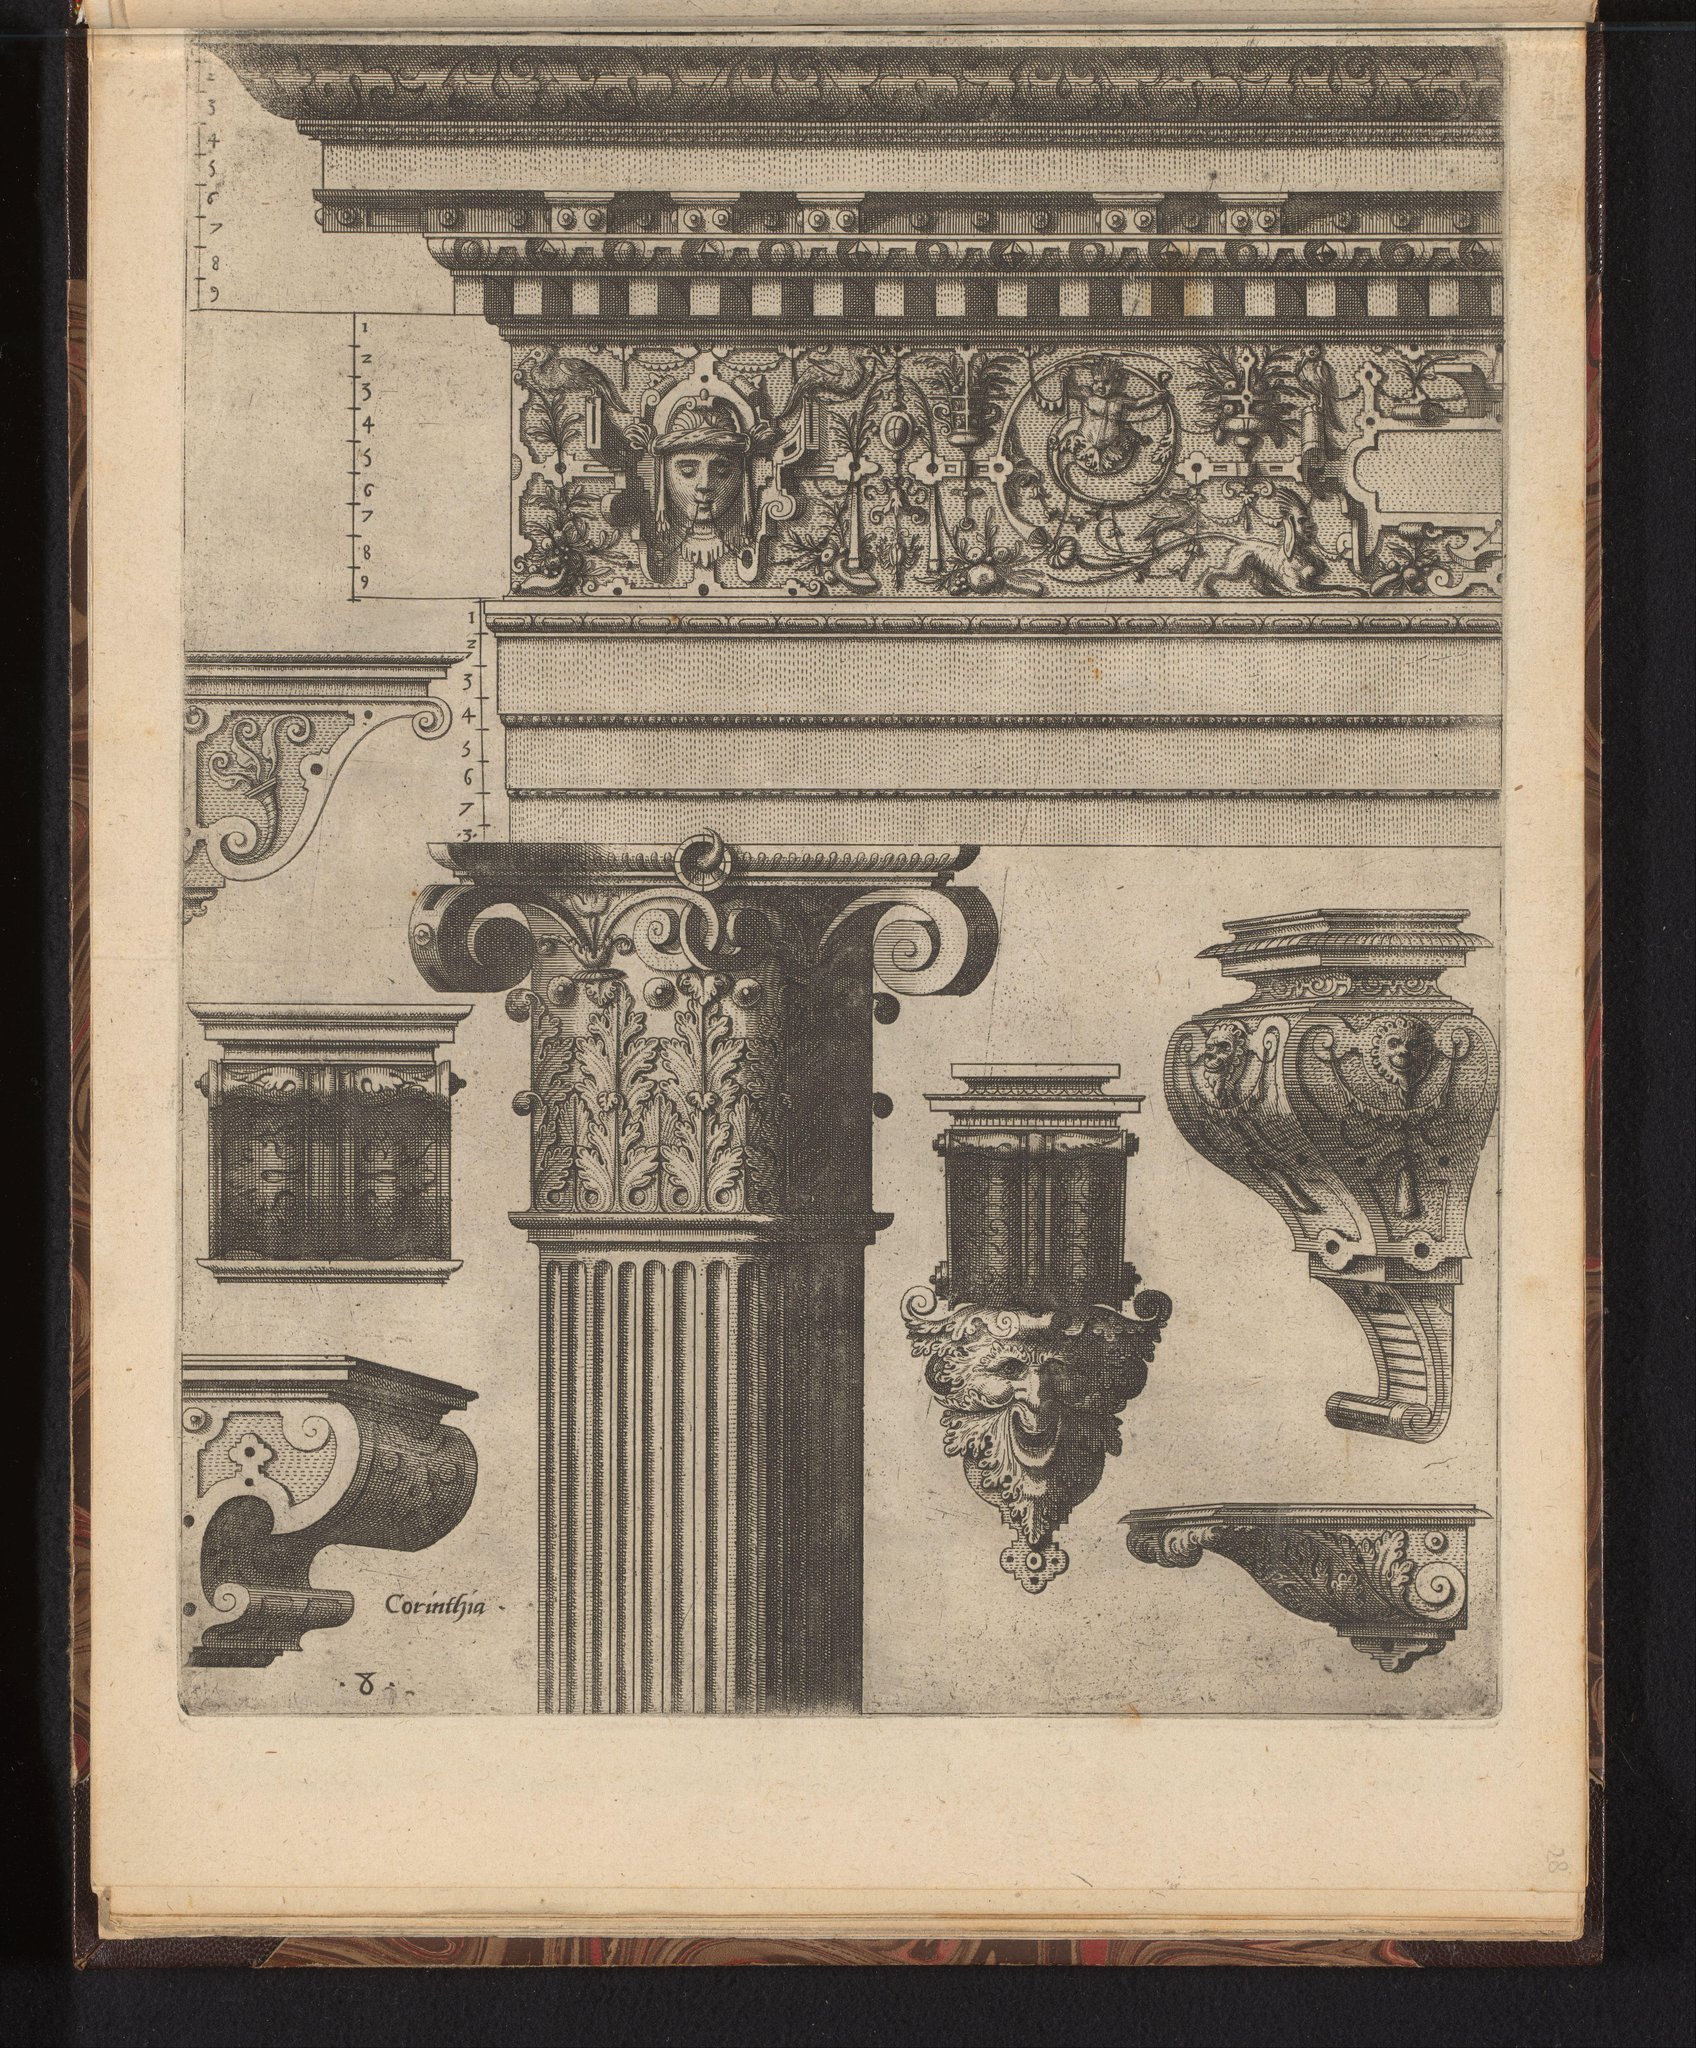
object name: album leaf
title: Korinthisch hoofdgestel met zes consoles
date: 1565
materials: paper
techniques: etching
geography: antwerp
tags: other architectural details (console), other architectural details (entablature), corinthian order ~ architecture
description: Korinthisch hoofdgestel. Het fries is gedecoreerd met een cartouche, een mascaron, rolwerk, grotesken en guirlandes. Daarbij zes losse consoles. Op de prent is drie maal een schaalverdeling aangegeven. De prent maakt deel uit van een album.